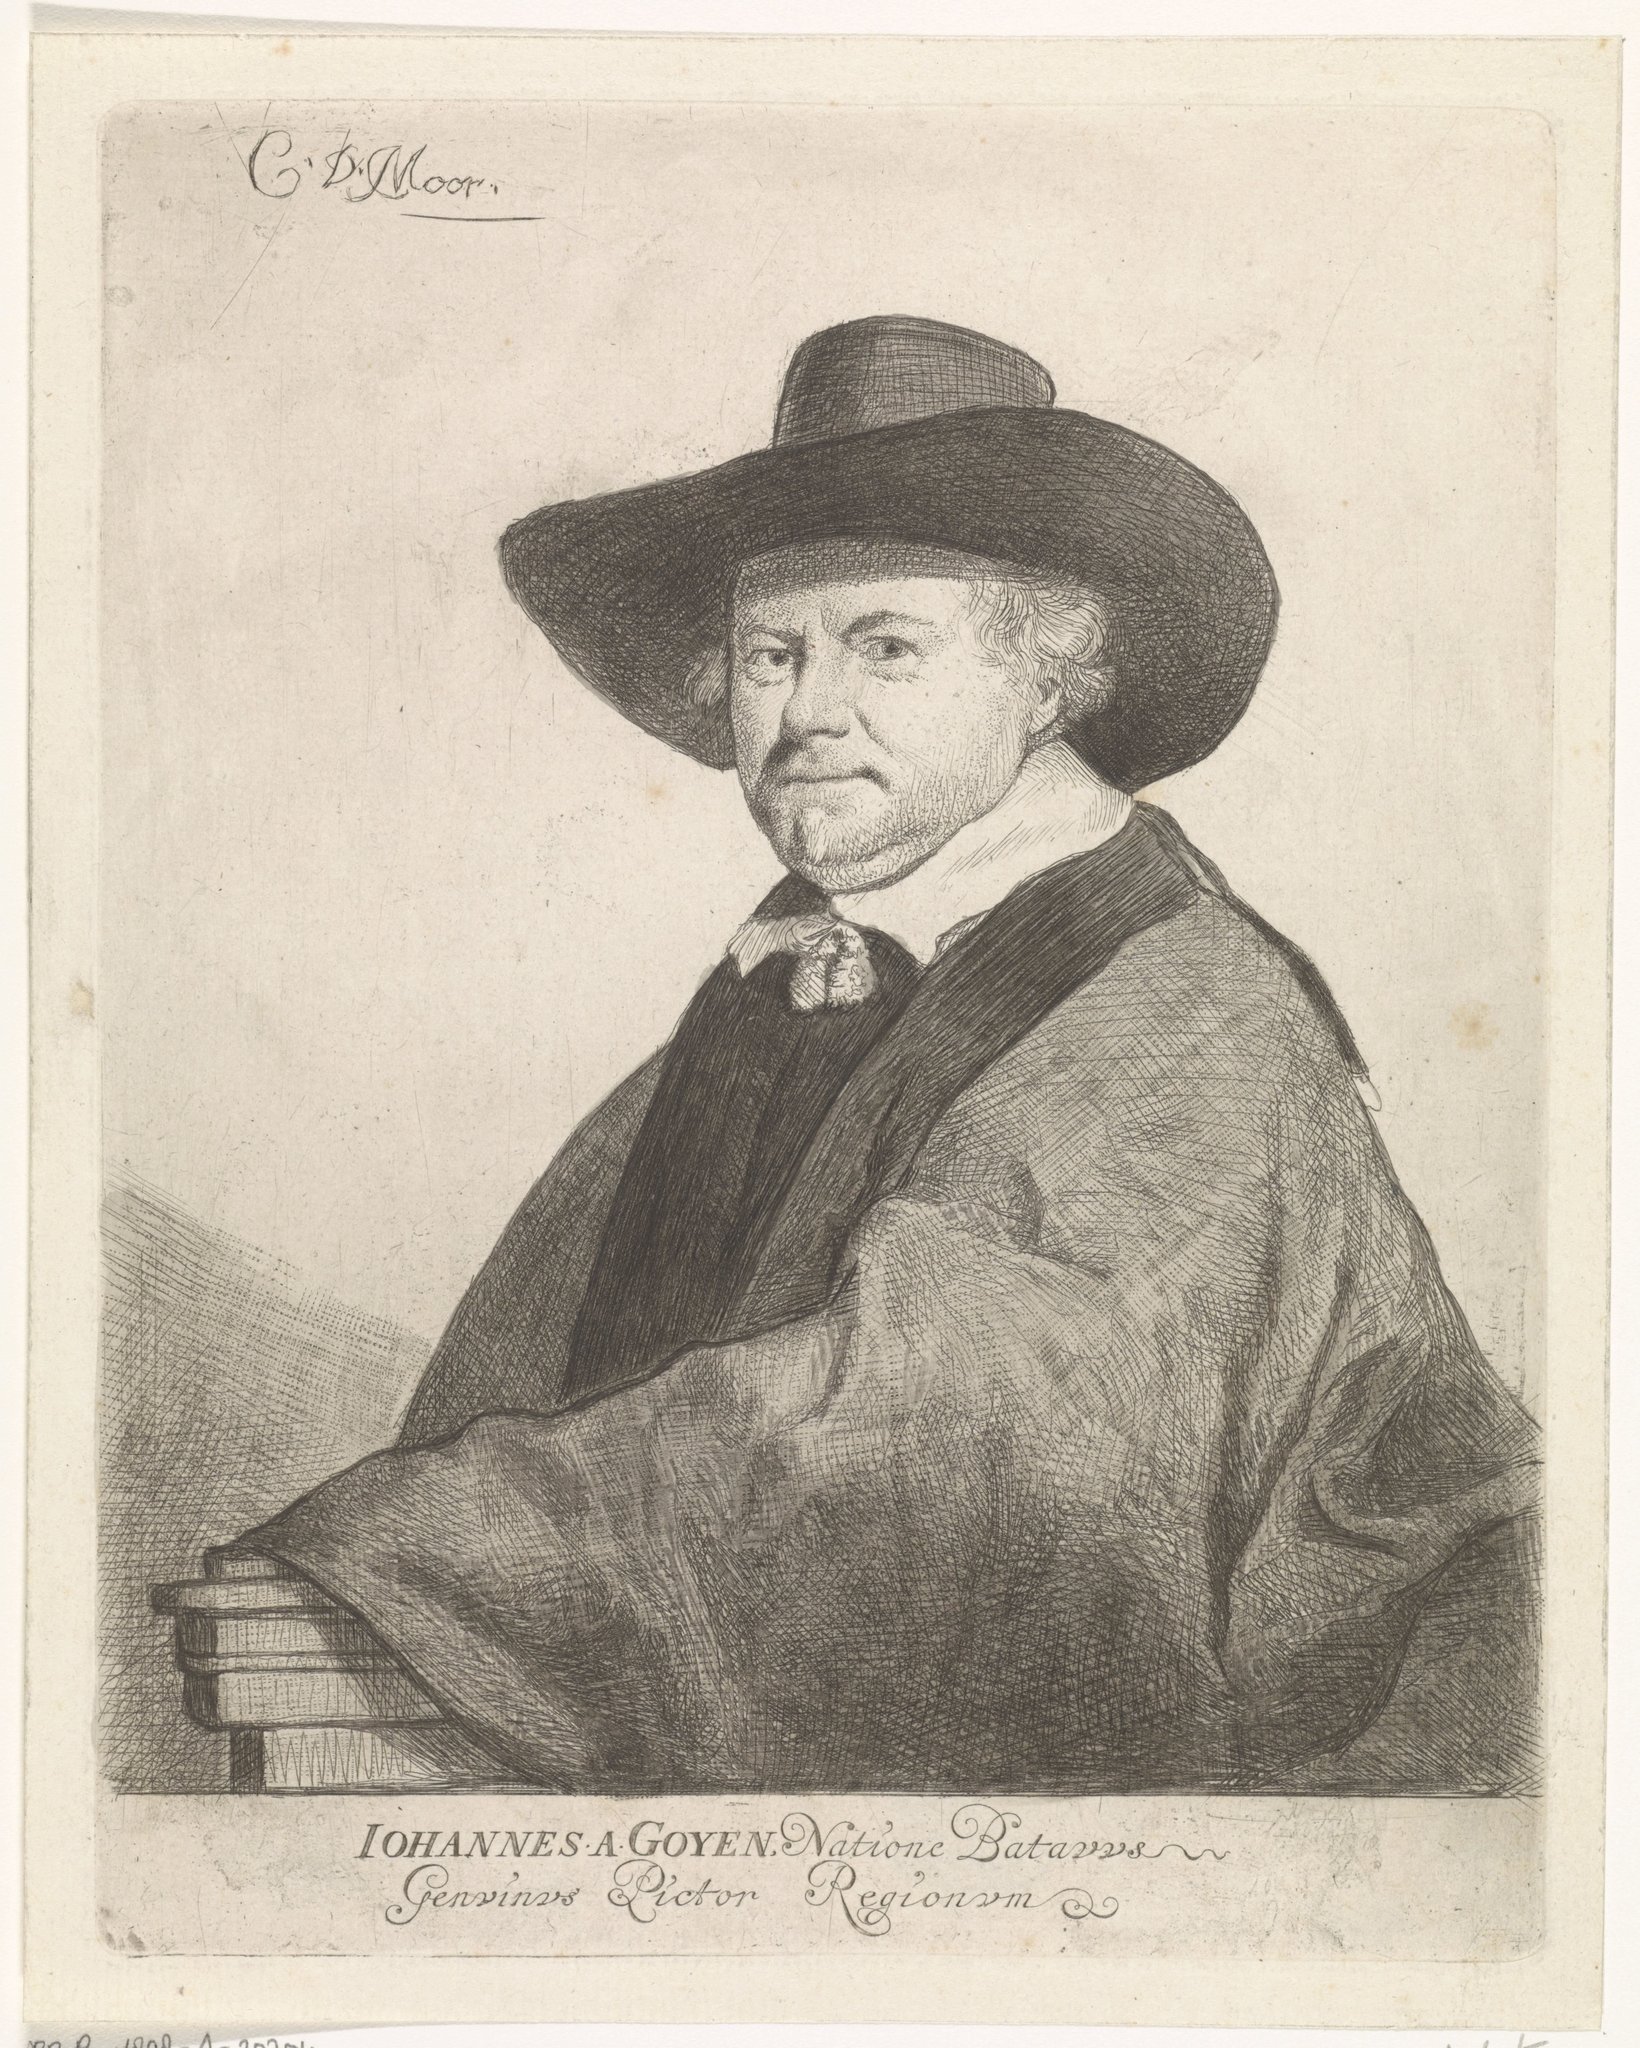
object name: print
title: Portret van Jan van Goyen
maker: carel de moor (ii)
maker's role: draughtsman, painter, print maker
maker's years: 1655-1738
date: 1665-1738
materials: paper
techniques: brush, engraving, etching, rocker stamped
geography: netherlands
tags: leiden, the hague, painter, draughtsman, jan van goyen, portrait, self-portrait of painter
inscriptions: collector's mark: Lugt 2228, collector's mark: Lugt 963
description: Portret van de schilder Jan van Goyen, met een hoed op het hoofd, gekleed in mantel, bij een pilaar.